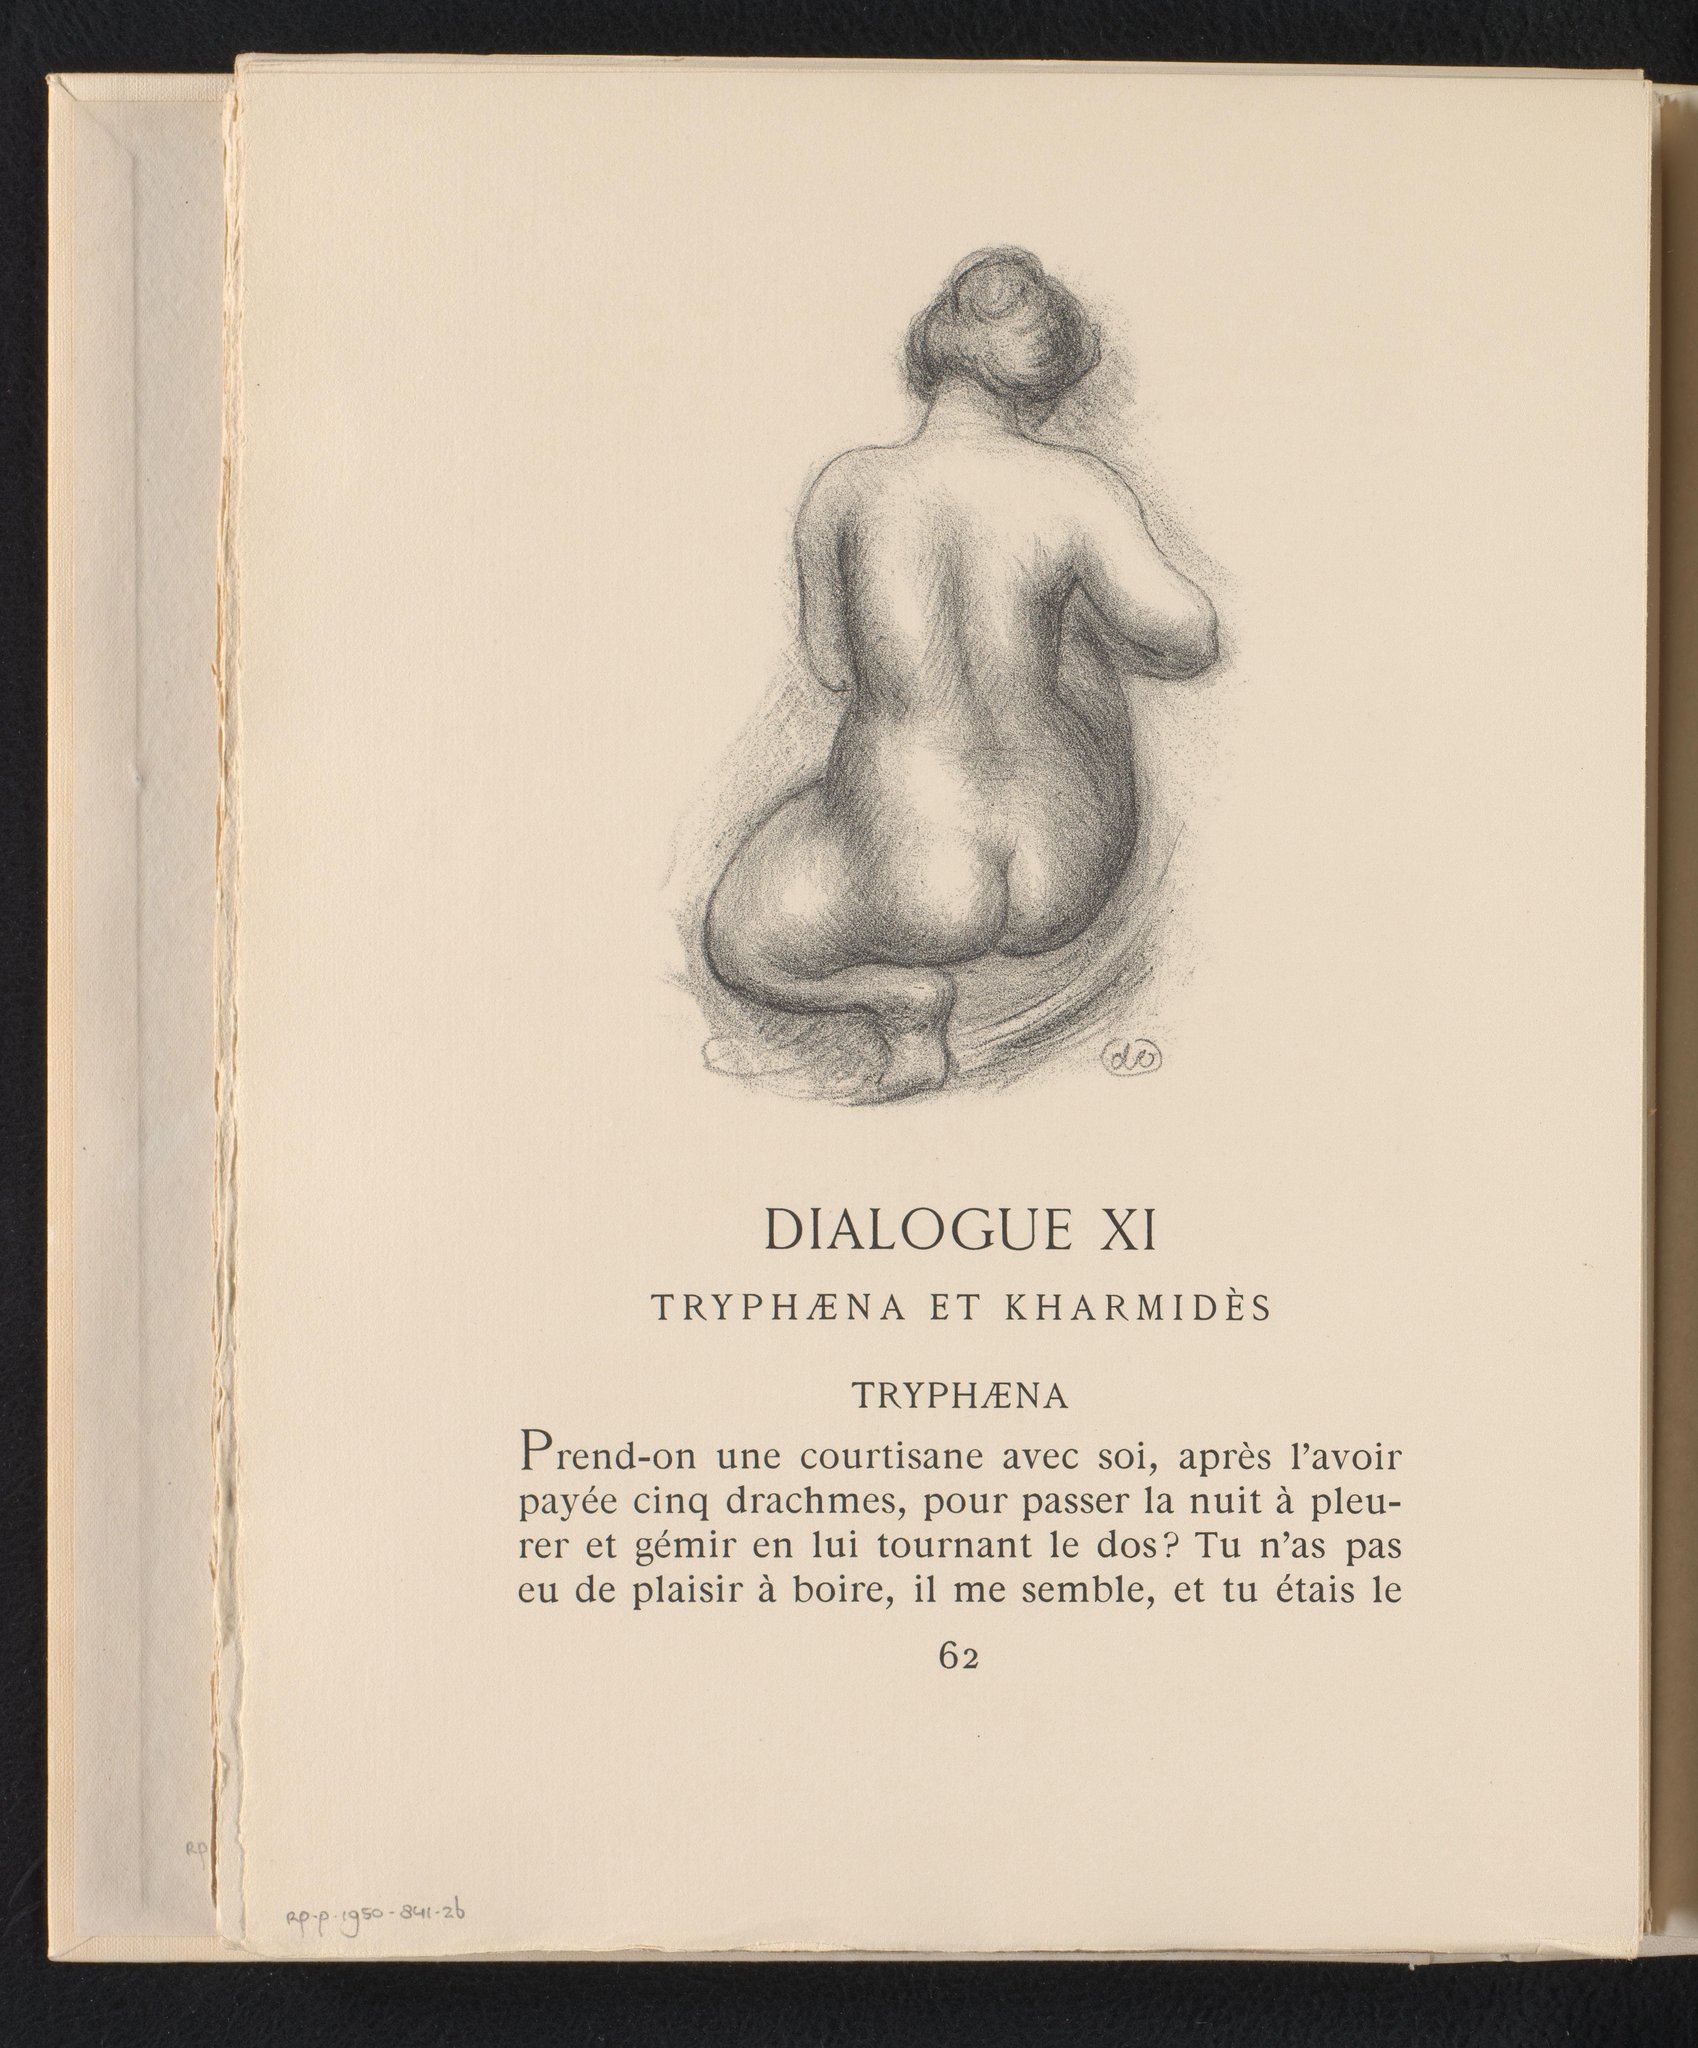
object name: book illustration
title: Naakte vrouw, knielend op een been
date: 1948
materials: paper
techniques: letterpress printing, lithograph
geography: paris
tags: kneeling figure - aa - female human figure, woman (showing herself) undressed, quasi-nude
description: Prent uit: Lucianus van Samosata. Dialogues des Courtisanes. [Vertaald uit het Grieks door] Charles Astruc. Parijs: s.n., 1948, p. 62.